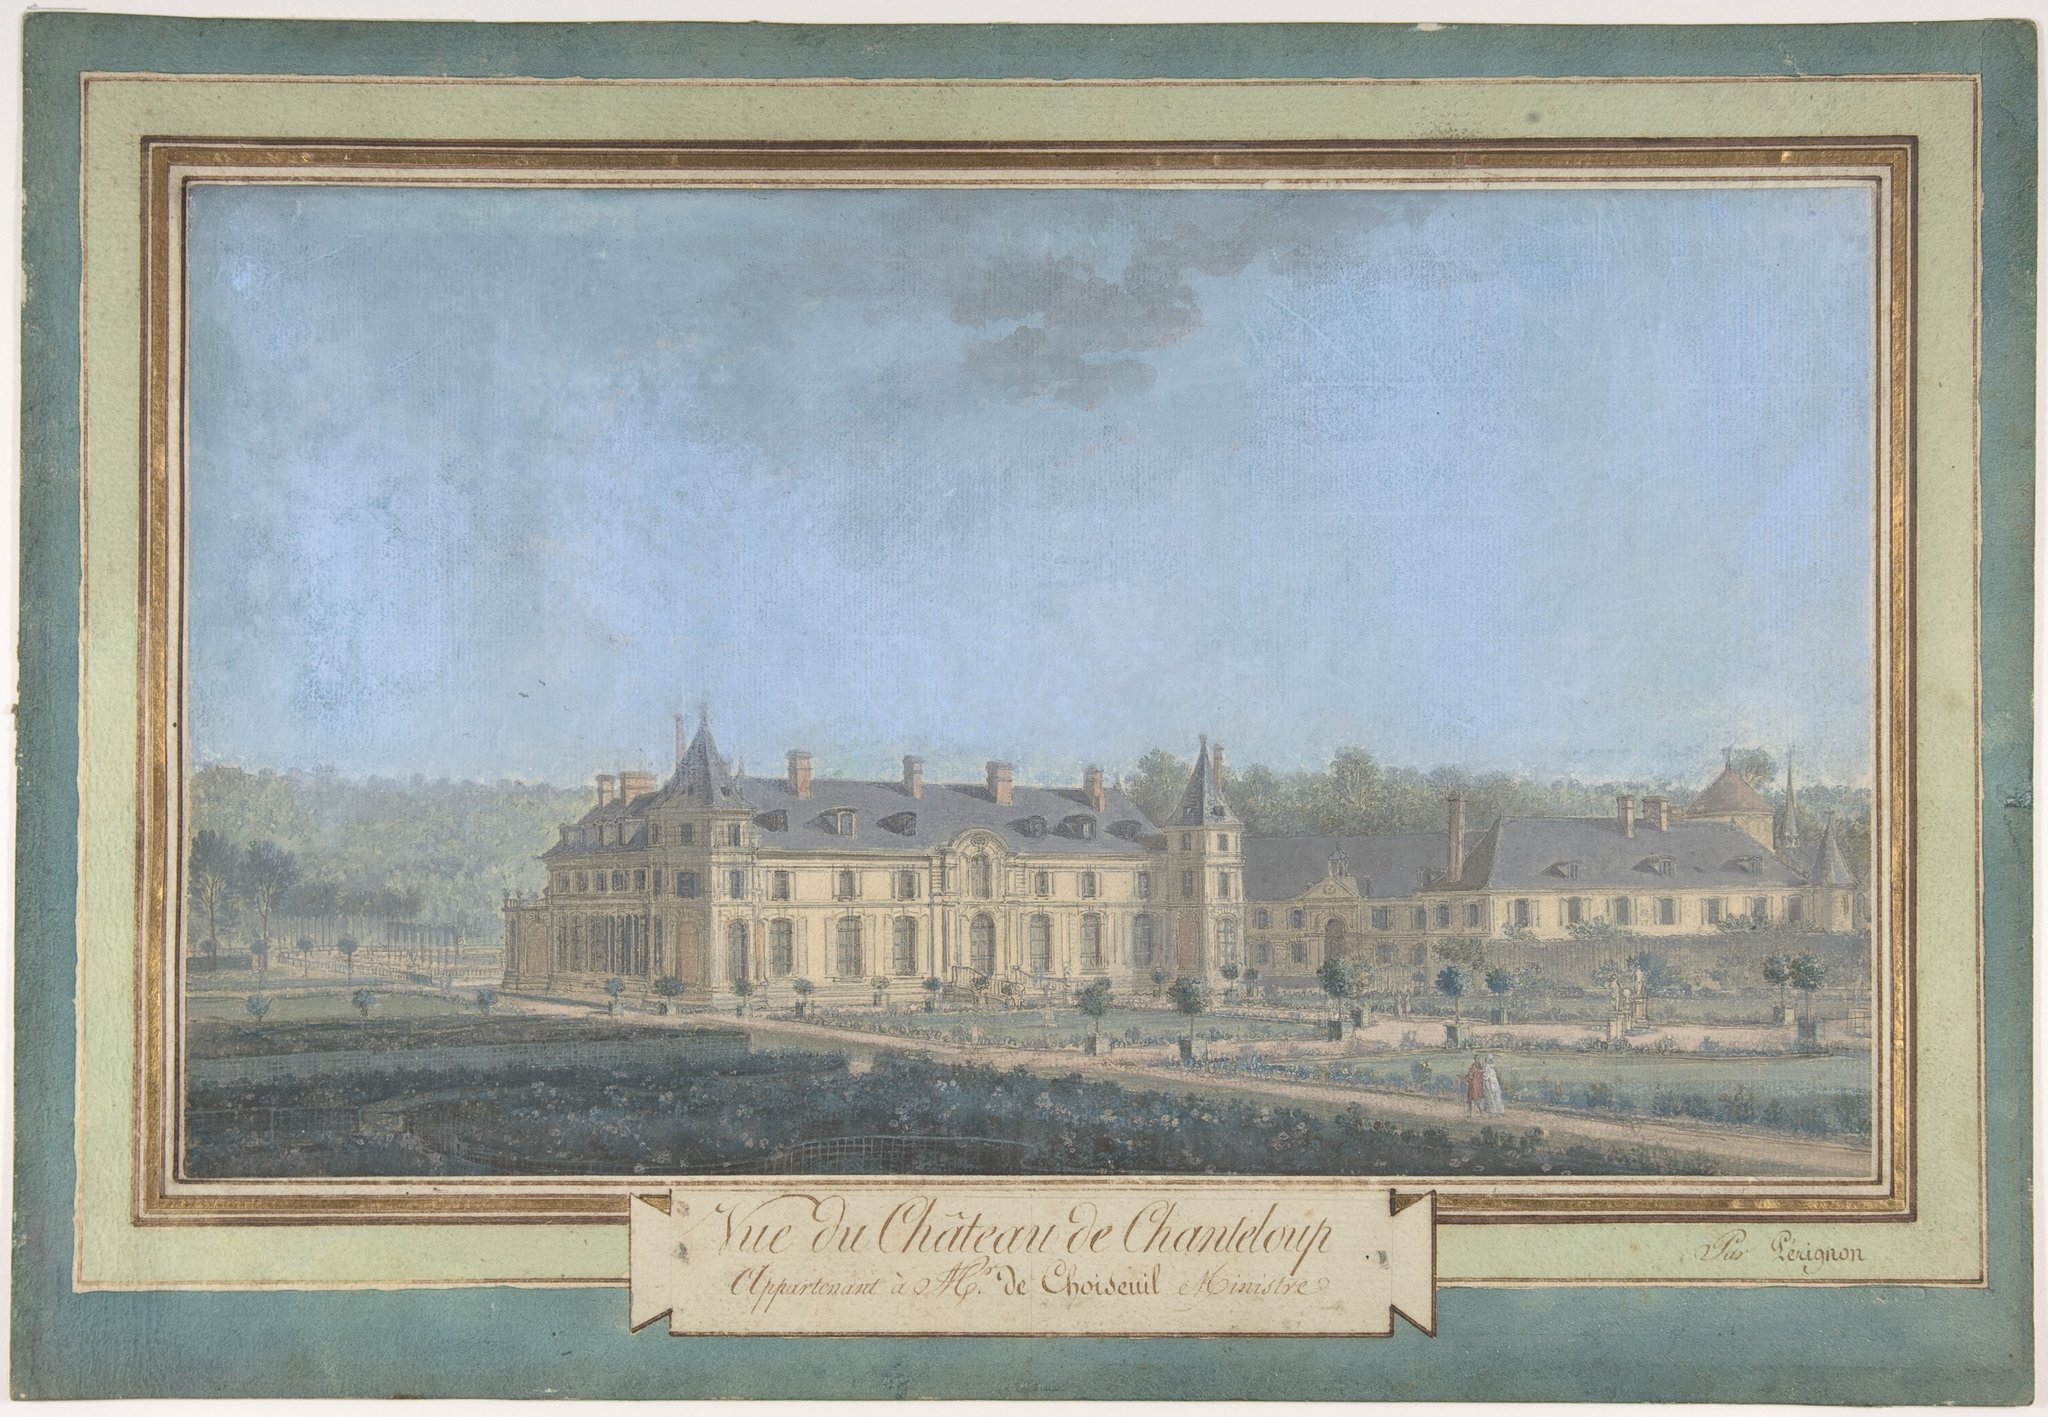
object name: drawing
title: View of a Château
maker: nicolas pérignon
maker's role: artist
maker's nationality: french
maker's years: 1726-1782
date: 1701-1800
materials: chalk, gouache, ink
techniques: pen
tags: buildings